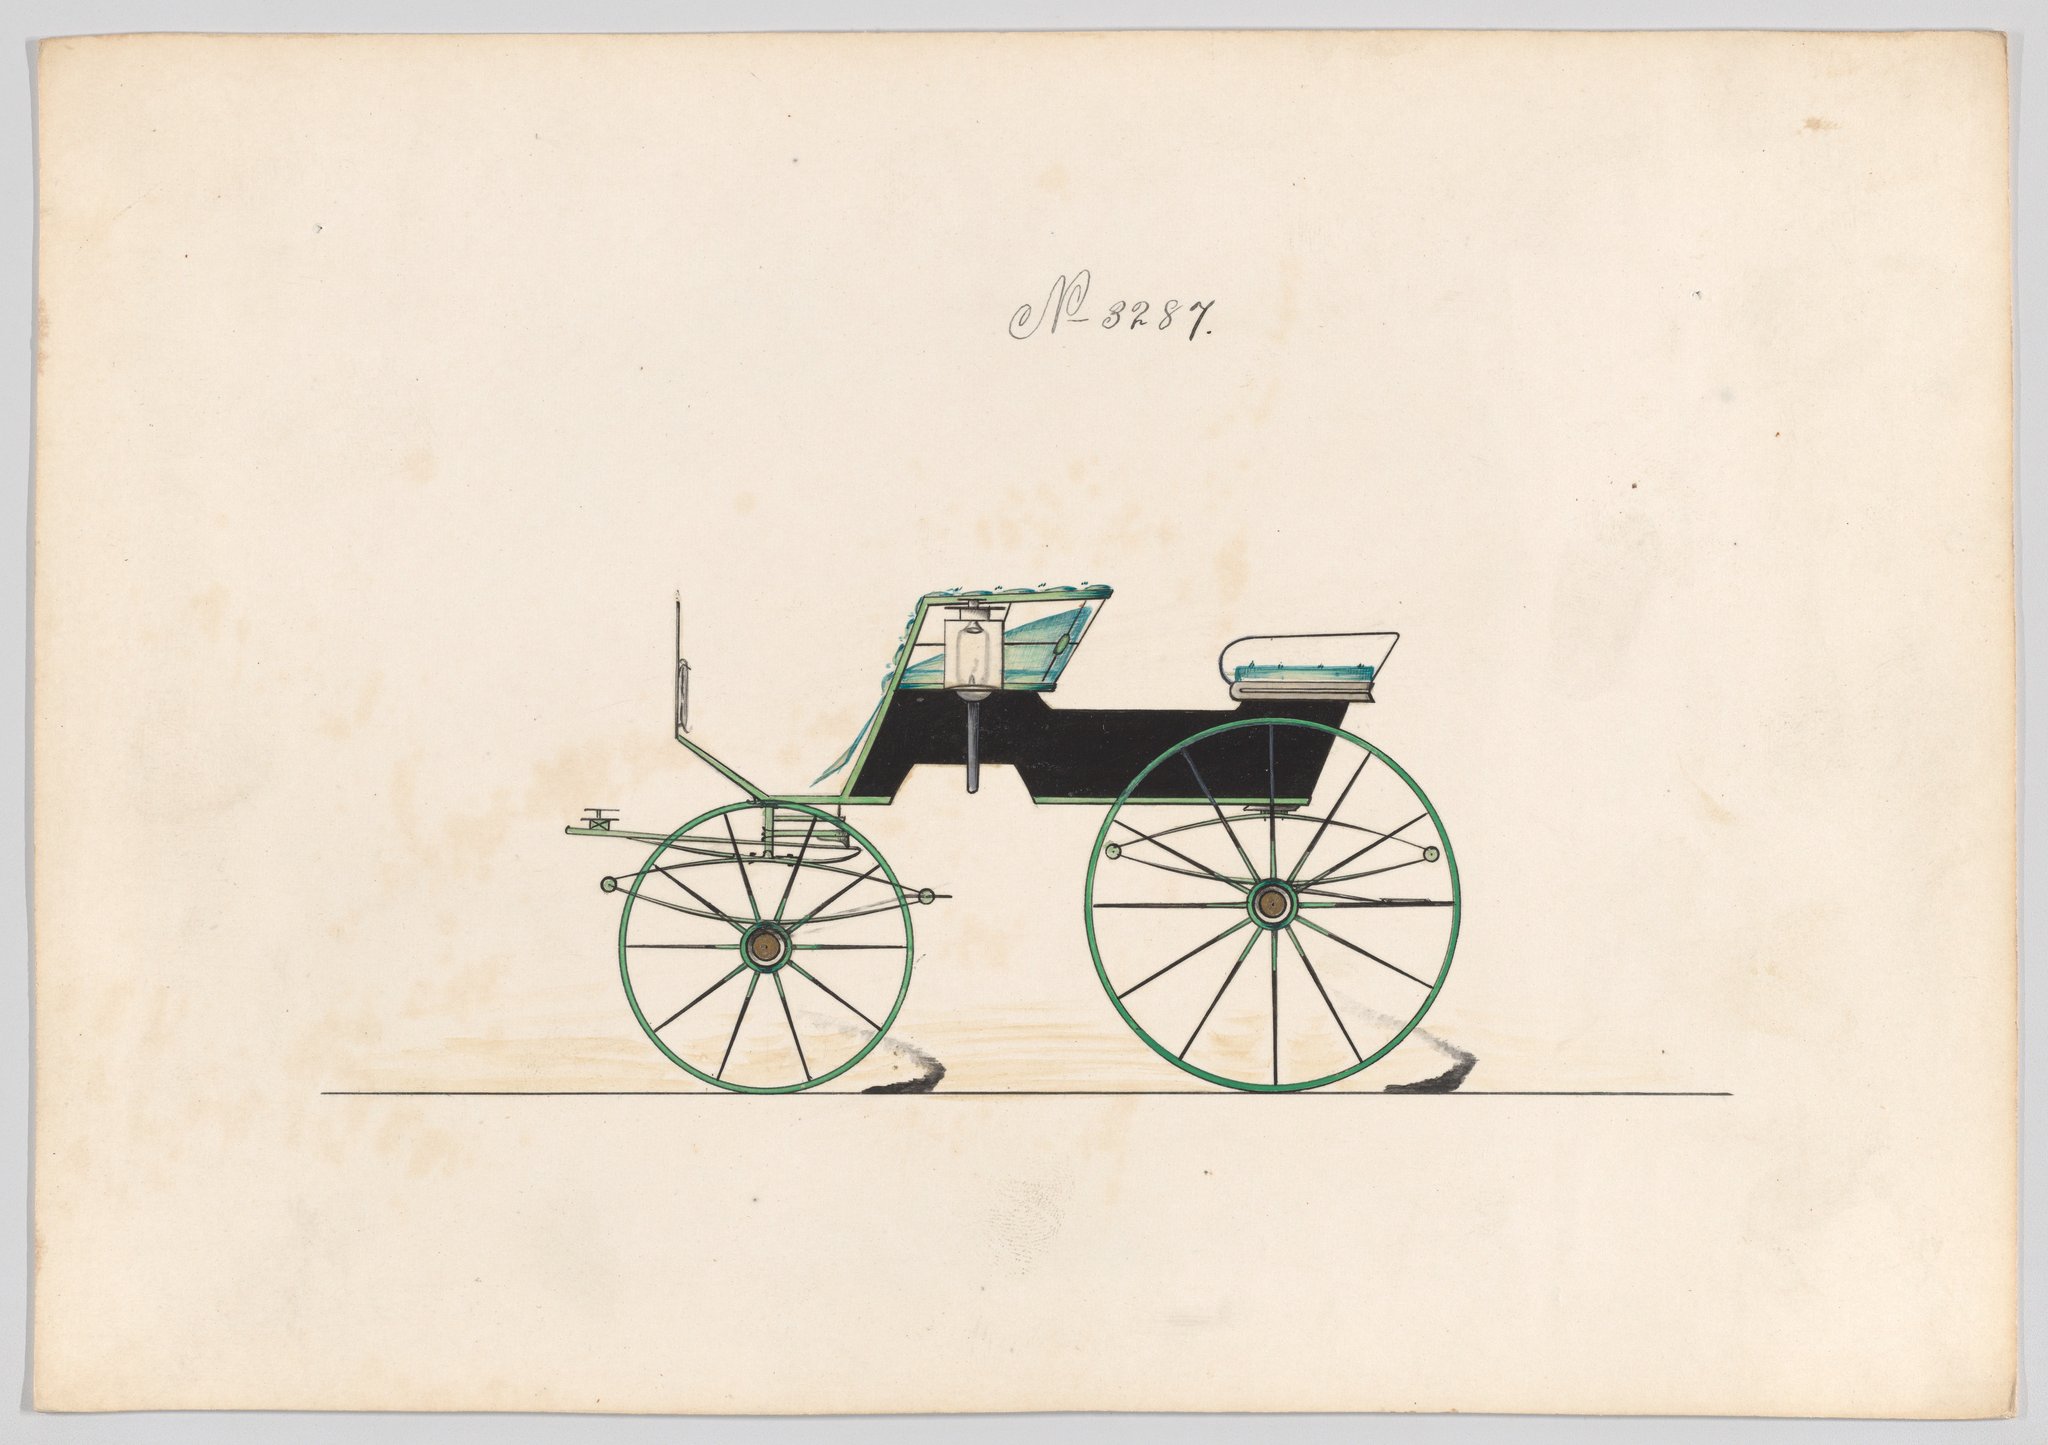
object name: drawing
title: Design for T-Cart, no. 3287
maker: brewster & co.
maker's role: manufacturer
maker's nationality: american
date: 1876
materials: gouache, ink, watercolor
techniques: pen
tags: carriages